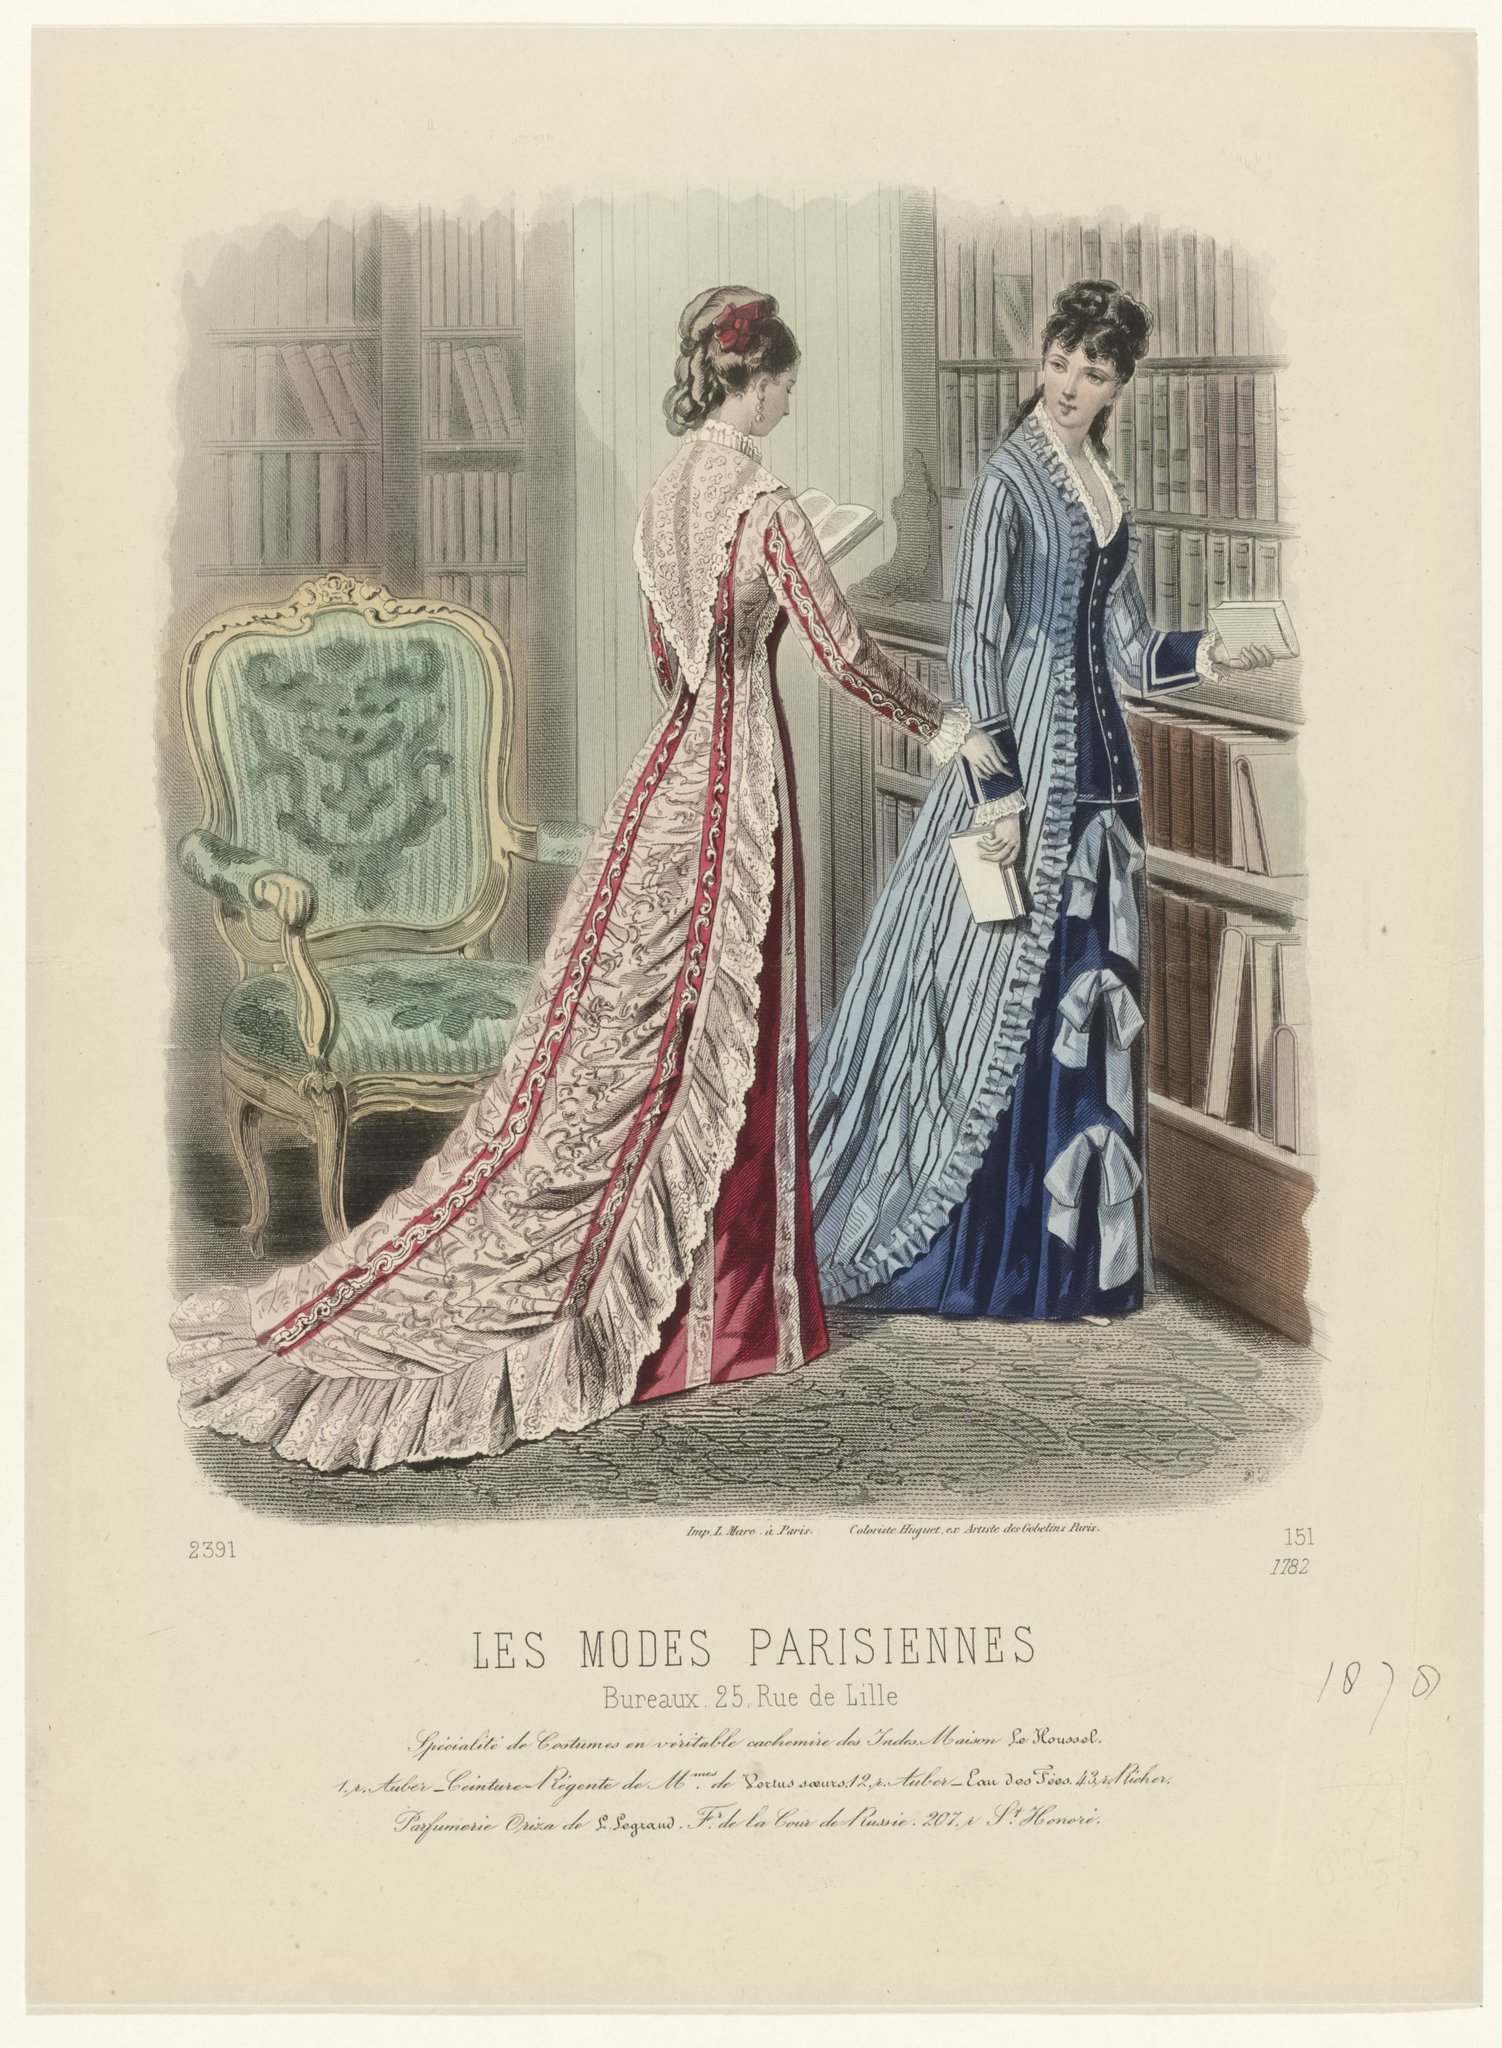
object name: fashion print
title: Les Modes Parisiennes, 1878, No. 1782 : Spécialité de Costumes, (...)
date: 1878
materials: paper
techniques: engraving, hand coloring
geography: paris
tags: bow (ornamental part of clothing) (+ women's clothes), armchair, seat, border, ribbon, braid (+ women's clothes), fashion plates, dress, gown (+ women's clothes), book - mm - book open, cupboard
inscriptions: address: ‘Bureaux, 25, Rue de Lille’, caption: ‘Spécialité de Costumes en véritables cachemire des Indes maison Le Houssel. 1. e. Auber_ Ceinture-Régente de M.mes de Vertus soeurs, 12, r, Auber_ Eau des Fées, 43, r, Richer. Parfumerie Oriza de L.Legrand, F.r de la Cour de Russie, 207, r S.t Honoré’, title: ‘LES MODES PARISIENNES’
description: Twee vrouwen, van wie één op de rug gezien, in een bibliotheek; zij staan met enkele boeken in de handen bij een boekenkast. Onder de voorstelling enkele regels reclametekst voor verschillende producten. Prent uit het modetijdschrift Les Modes Parisiennes (1843-1885).